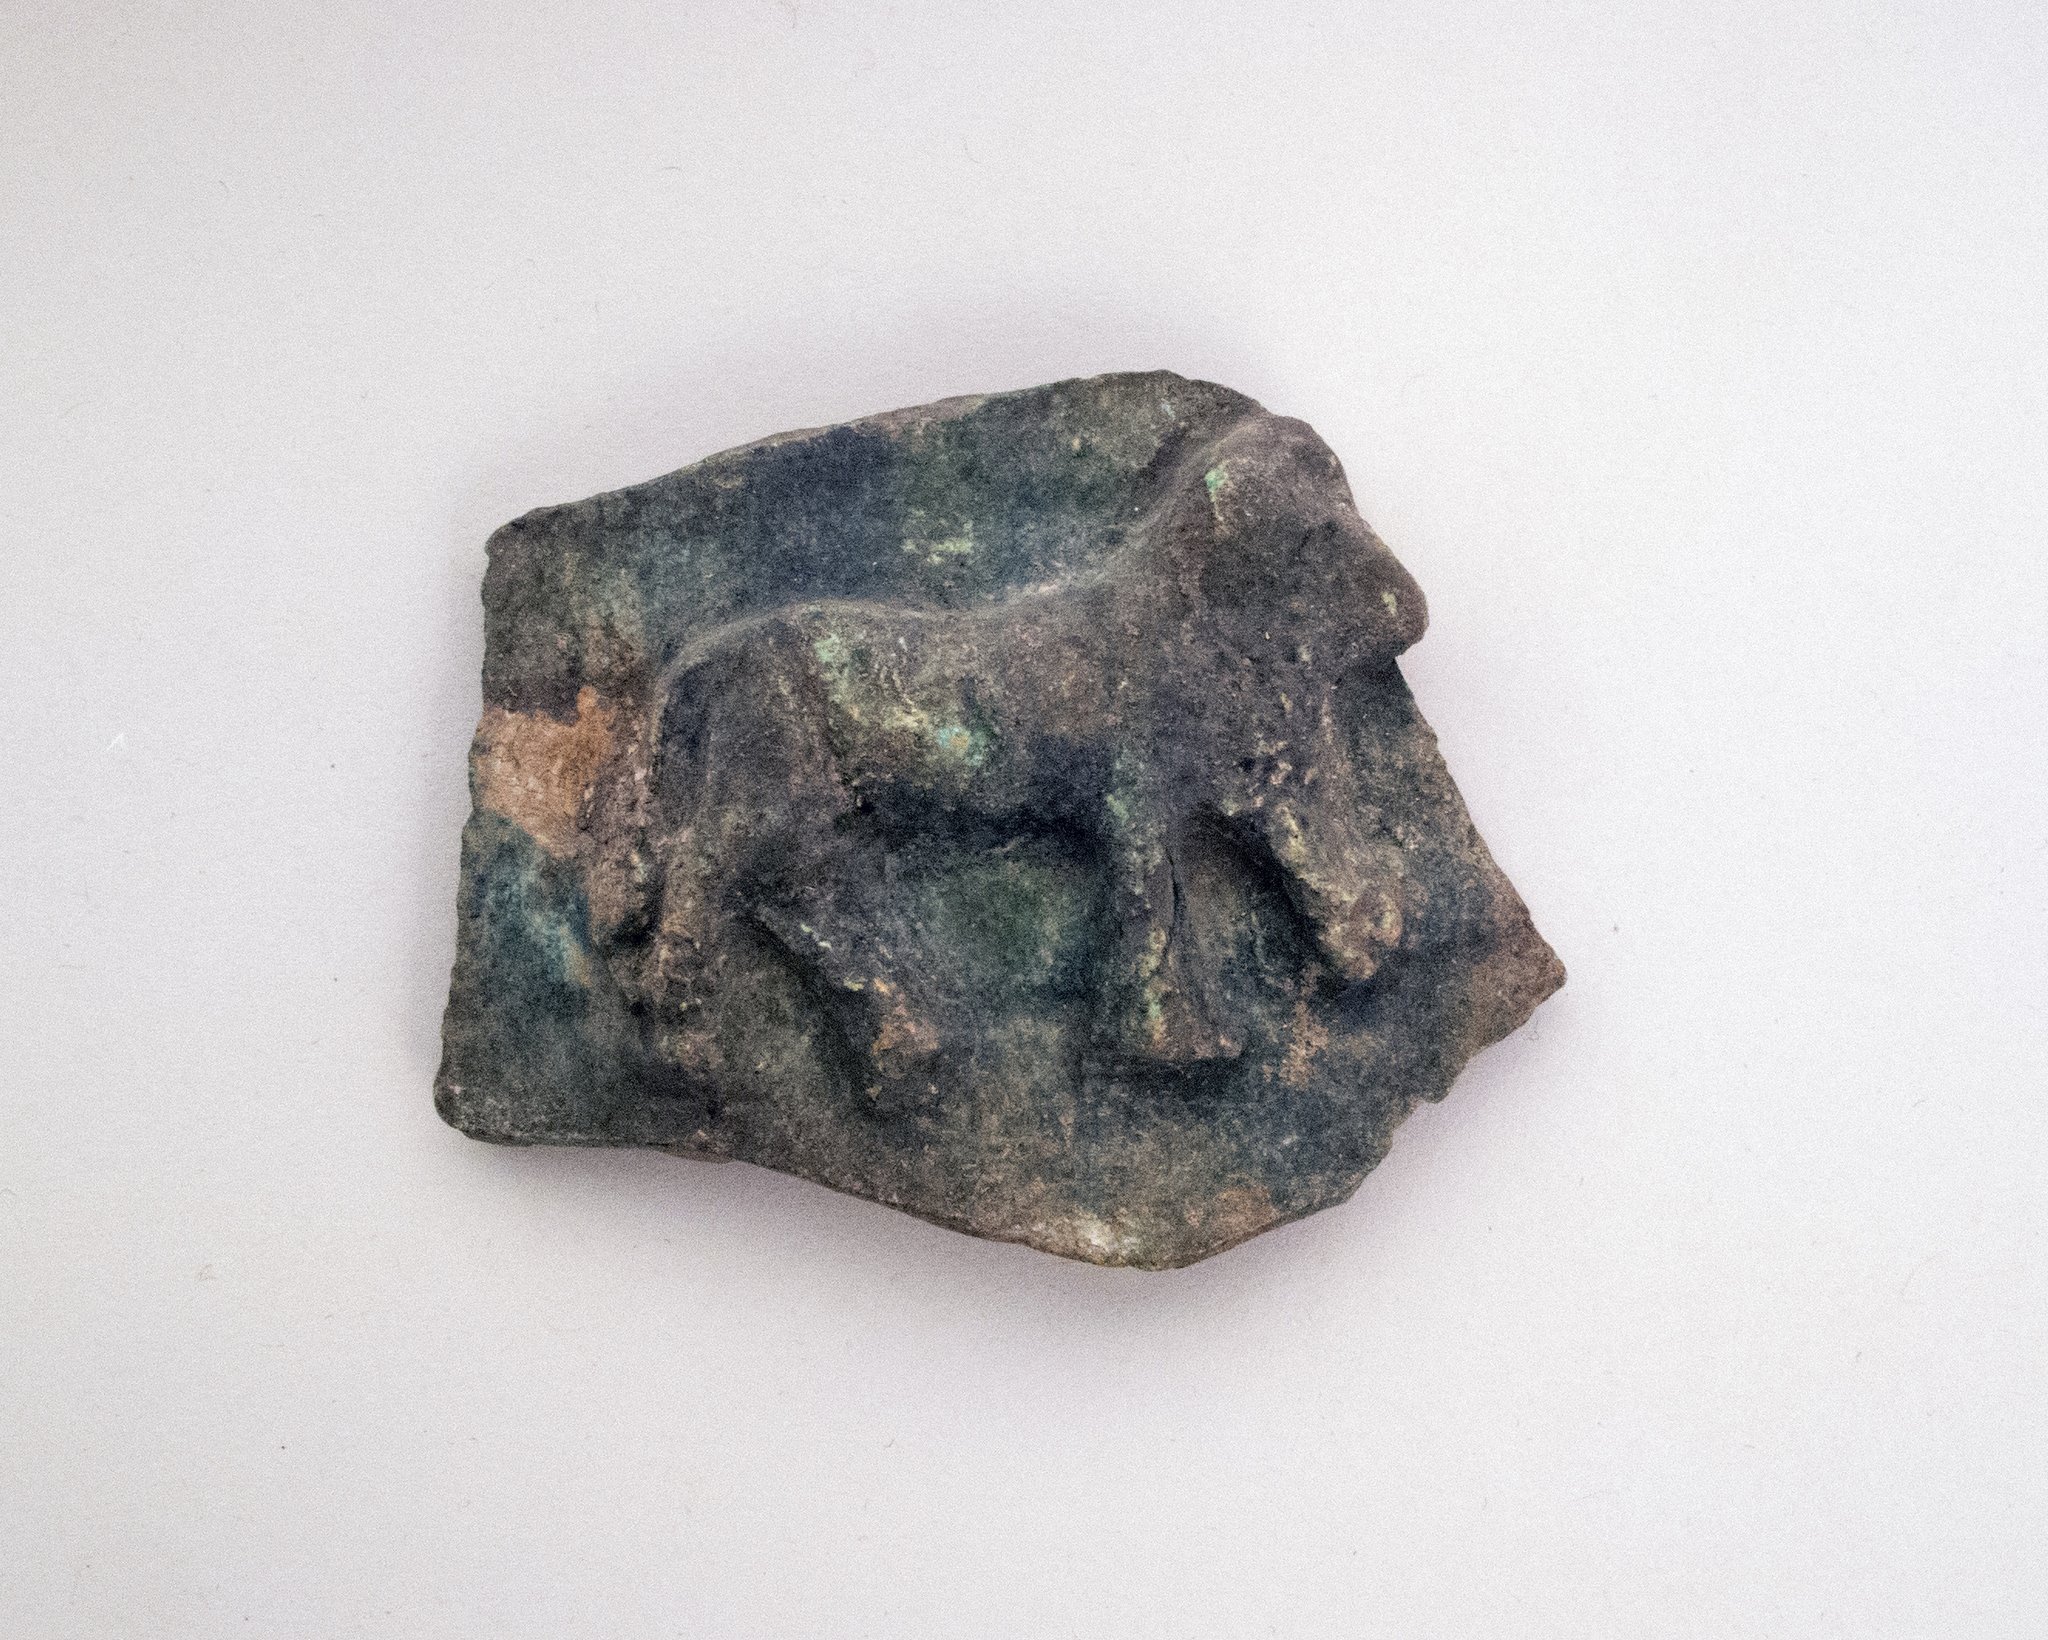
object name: vase fragment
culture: roman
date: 670 BCE-330 CE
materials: terracotta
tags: animals